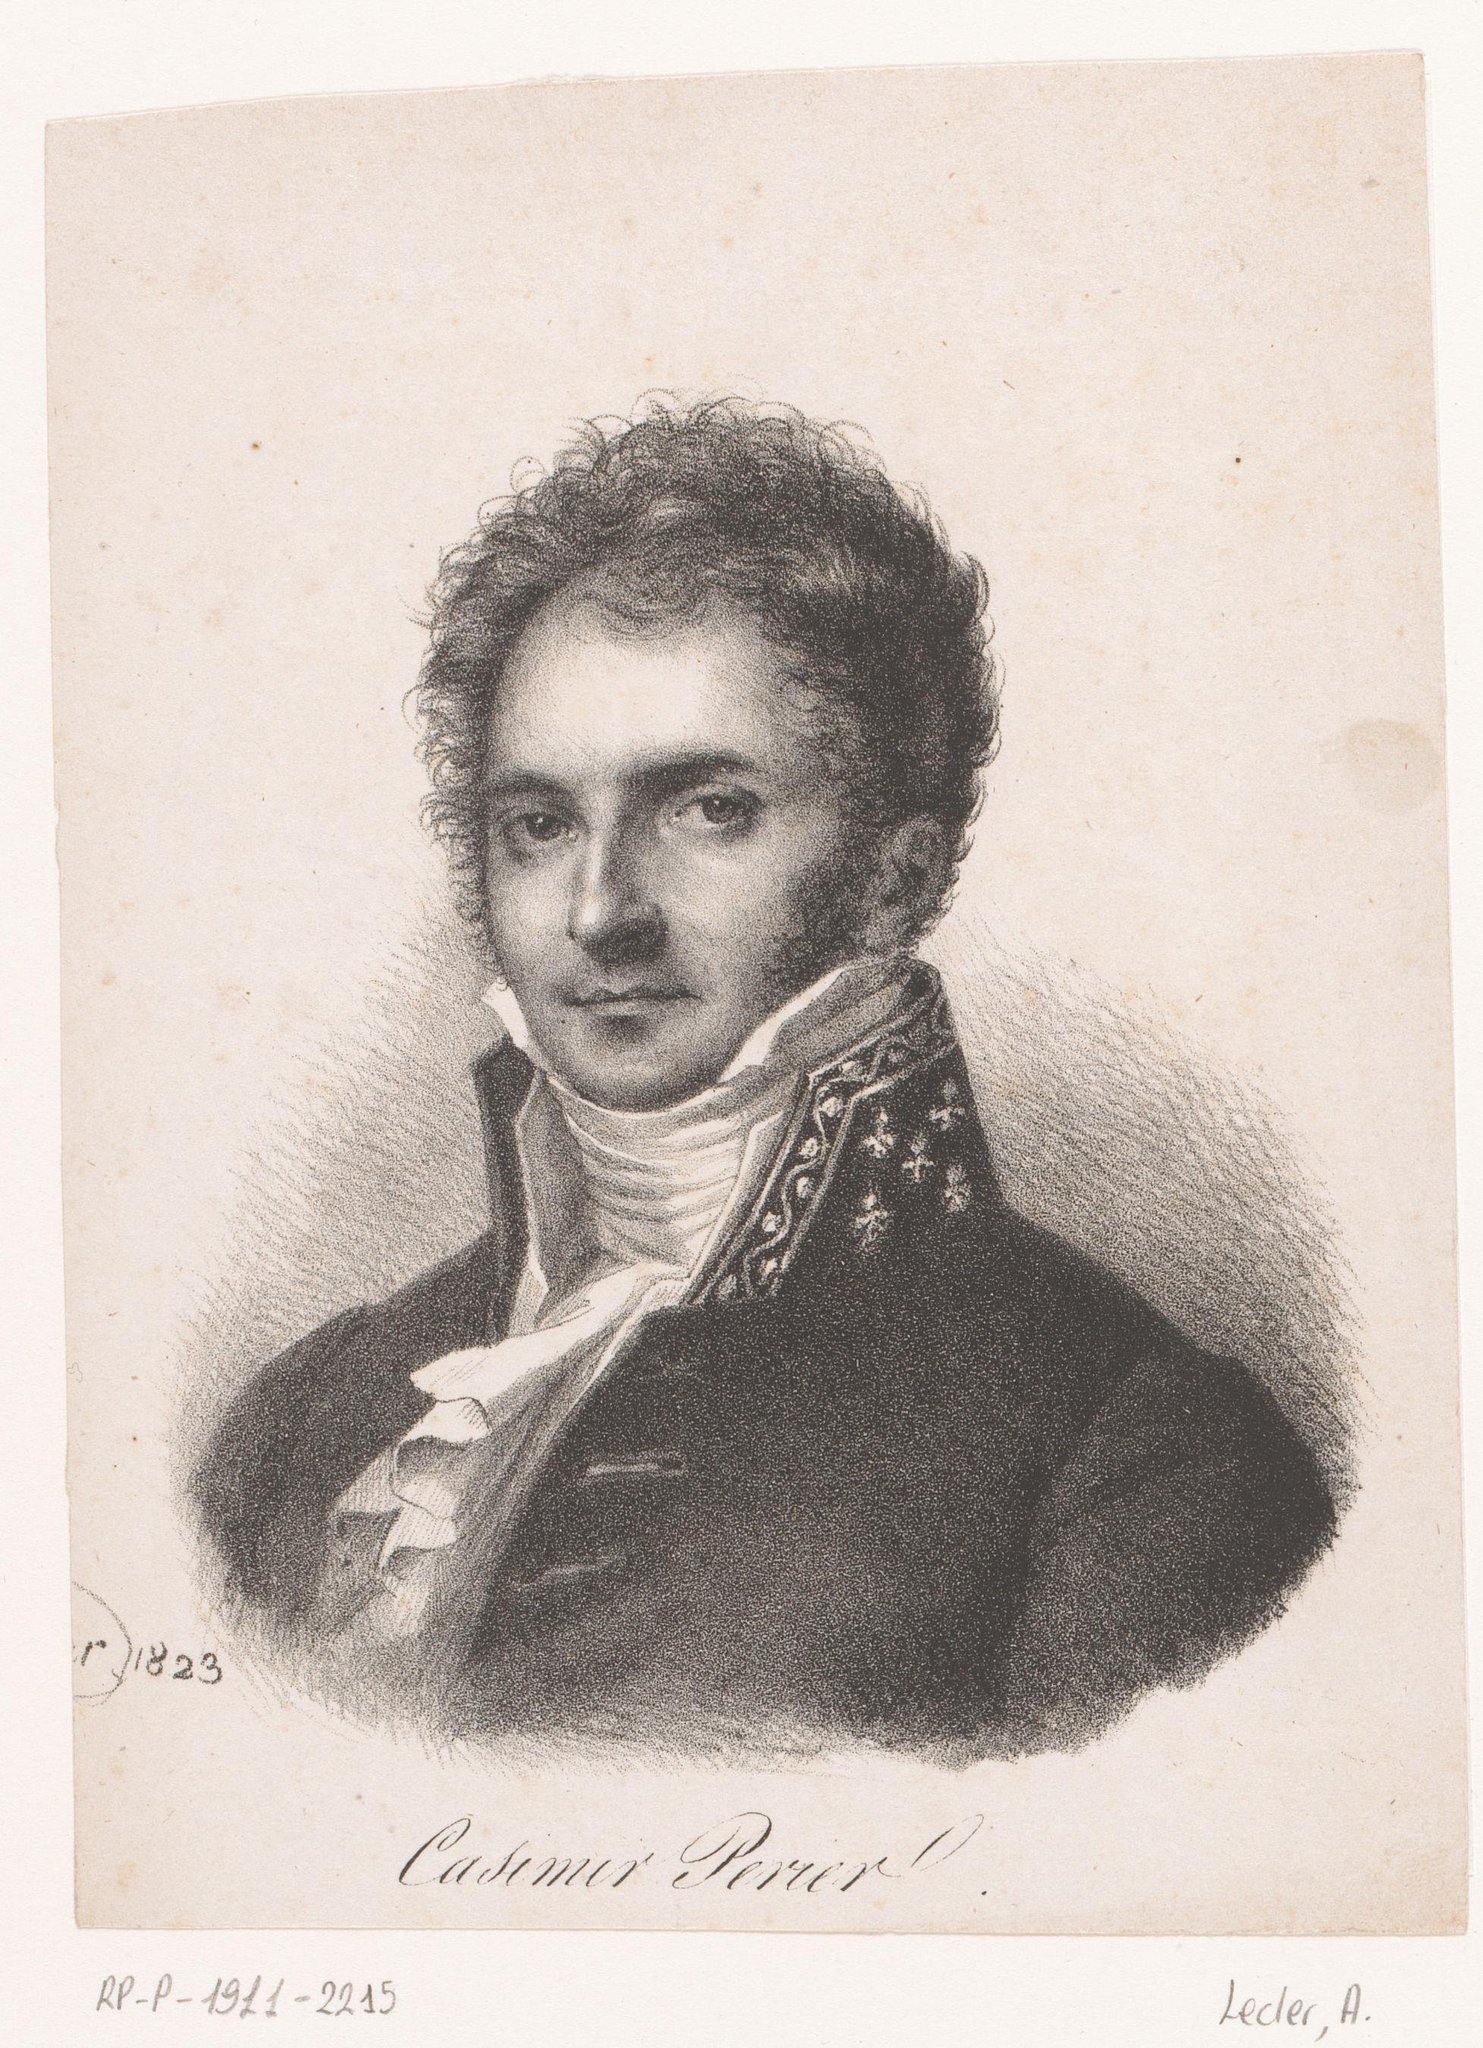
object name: print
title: Portret van Casimir-Pierre Perier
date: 1823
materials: paper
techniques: lithograph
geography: paris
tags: paris, politician, historical persons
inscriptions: collector's mark: Lugt 2228a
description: Deze prent was oorspronkelijk onderdeel van een blad met vier portretten. Het portret met Casimier Perier is losgeknipt.